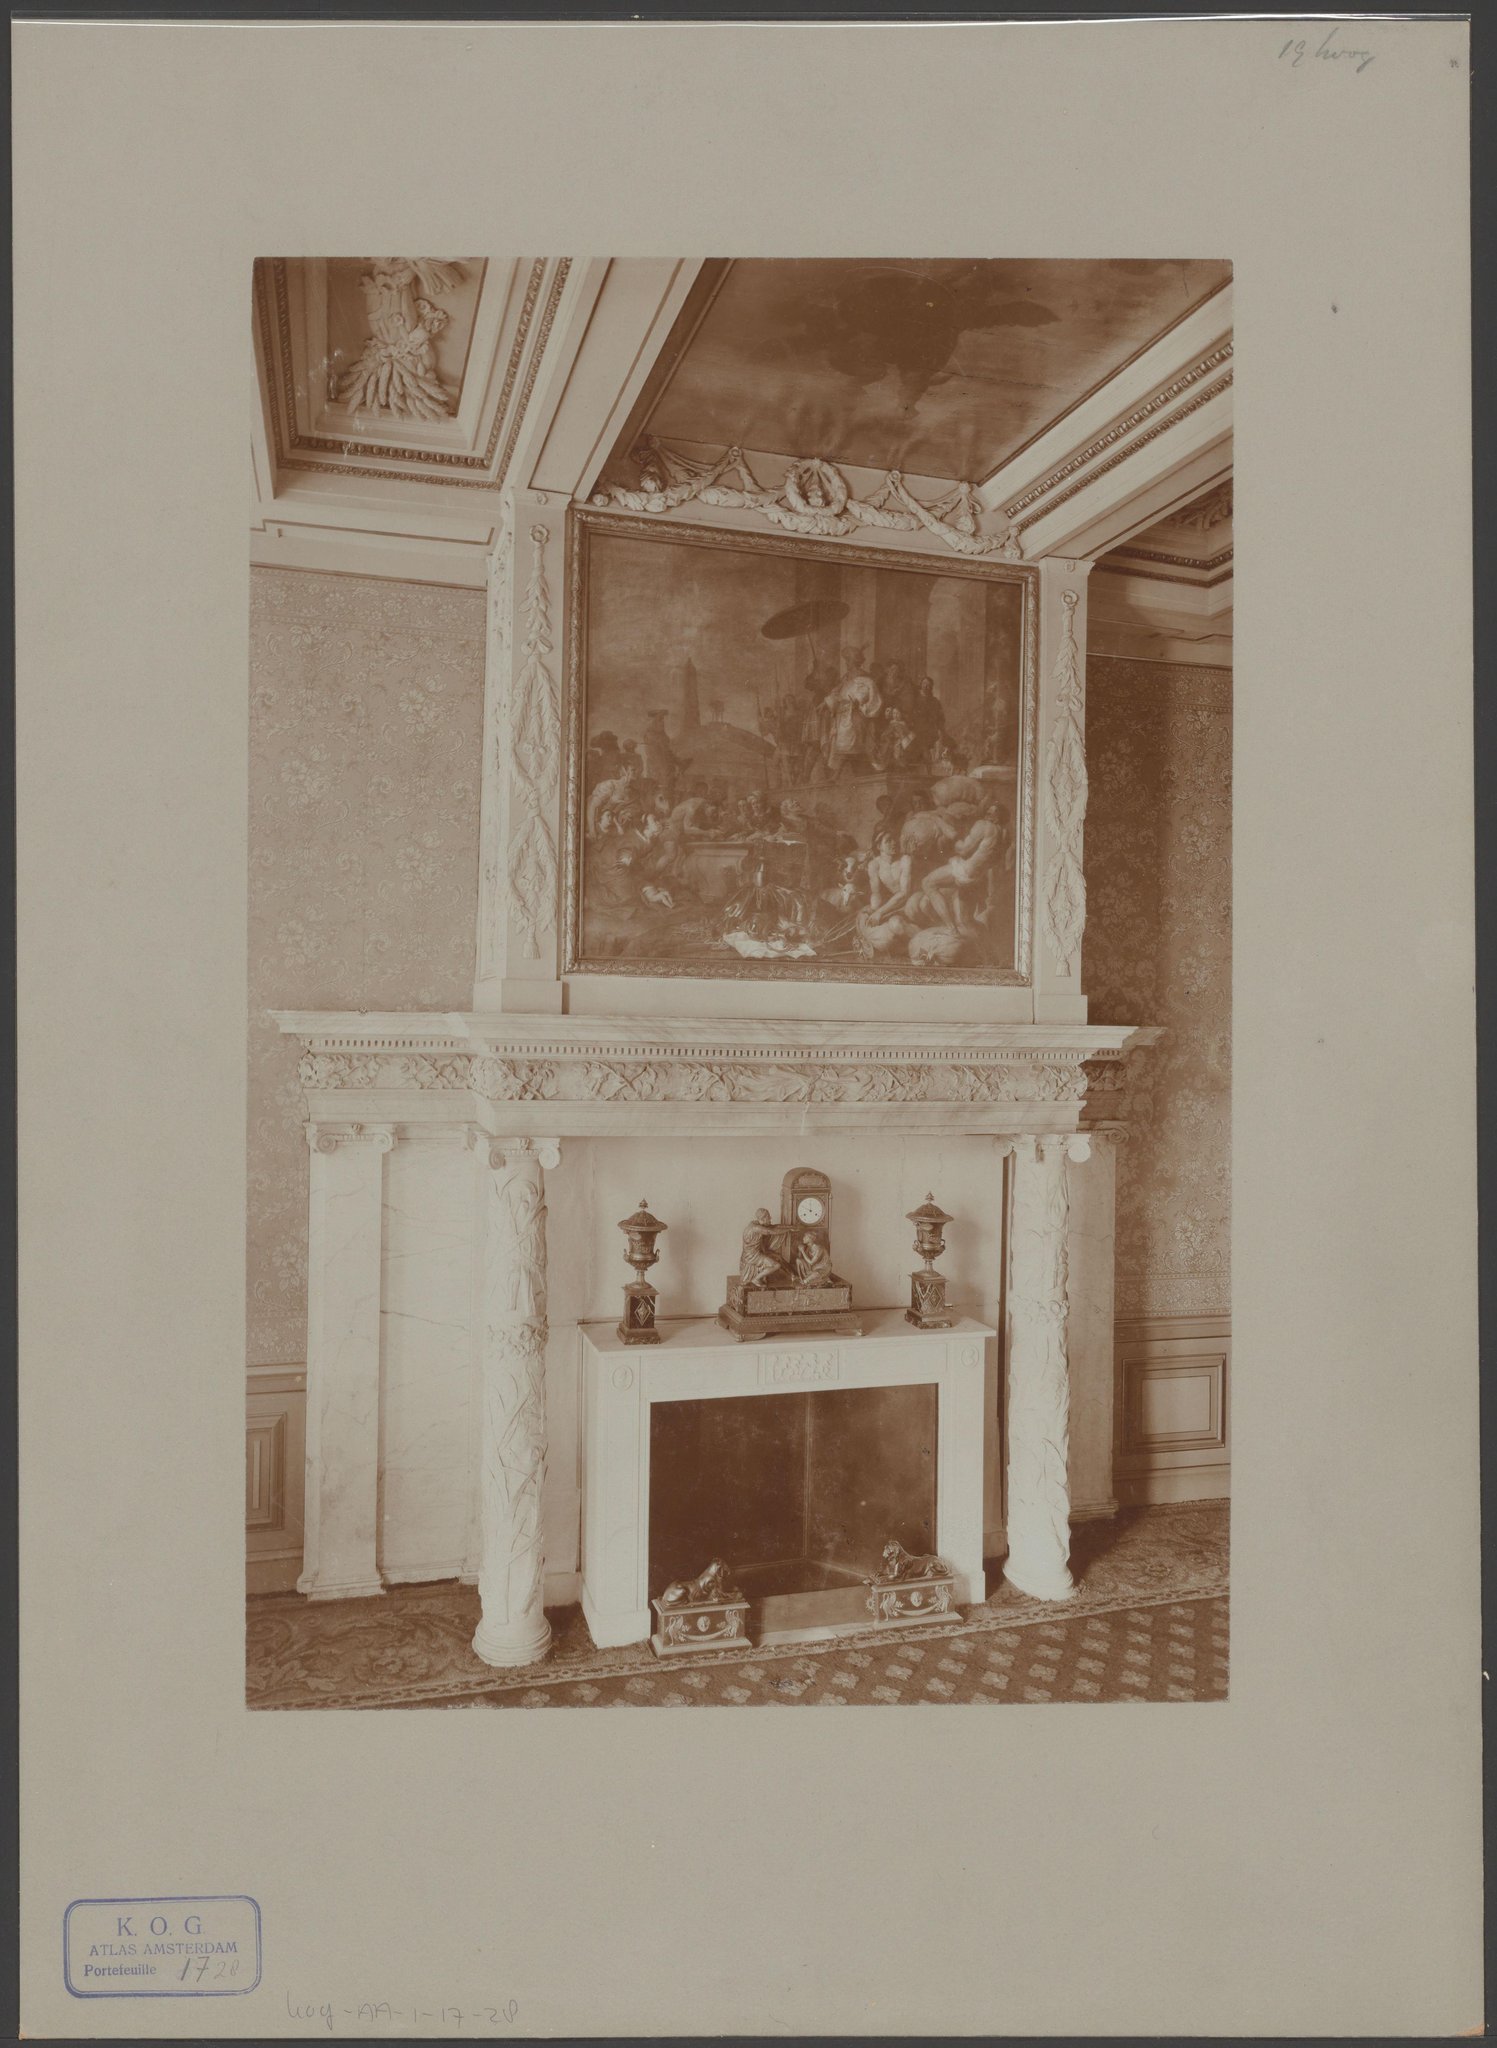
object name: photograph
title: Gezicht op de schoorsteen in de Thesaurie Ordinaris in het Paleis op de Dam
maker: Anonymous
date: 1865-1940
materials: paper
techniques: collodion silver print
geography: amsterdam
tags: chimney, townhall, chimney-piece, mantelpiece, royal palace of amsterdam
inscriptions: collector's mark: ‘17.28’ Lugt 1641b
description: Onderwerpsrubriek binnen de Atlas Amsterdam: Nieuwe Stadhuis, van binnen: Groote zaal, Raadkamer, Schepenkamer, Troonzaal, Mozeszaal, Zitkamer.